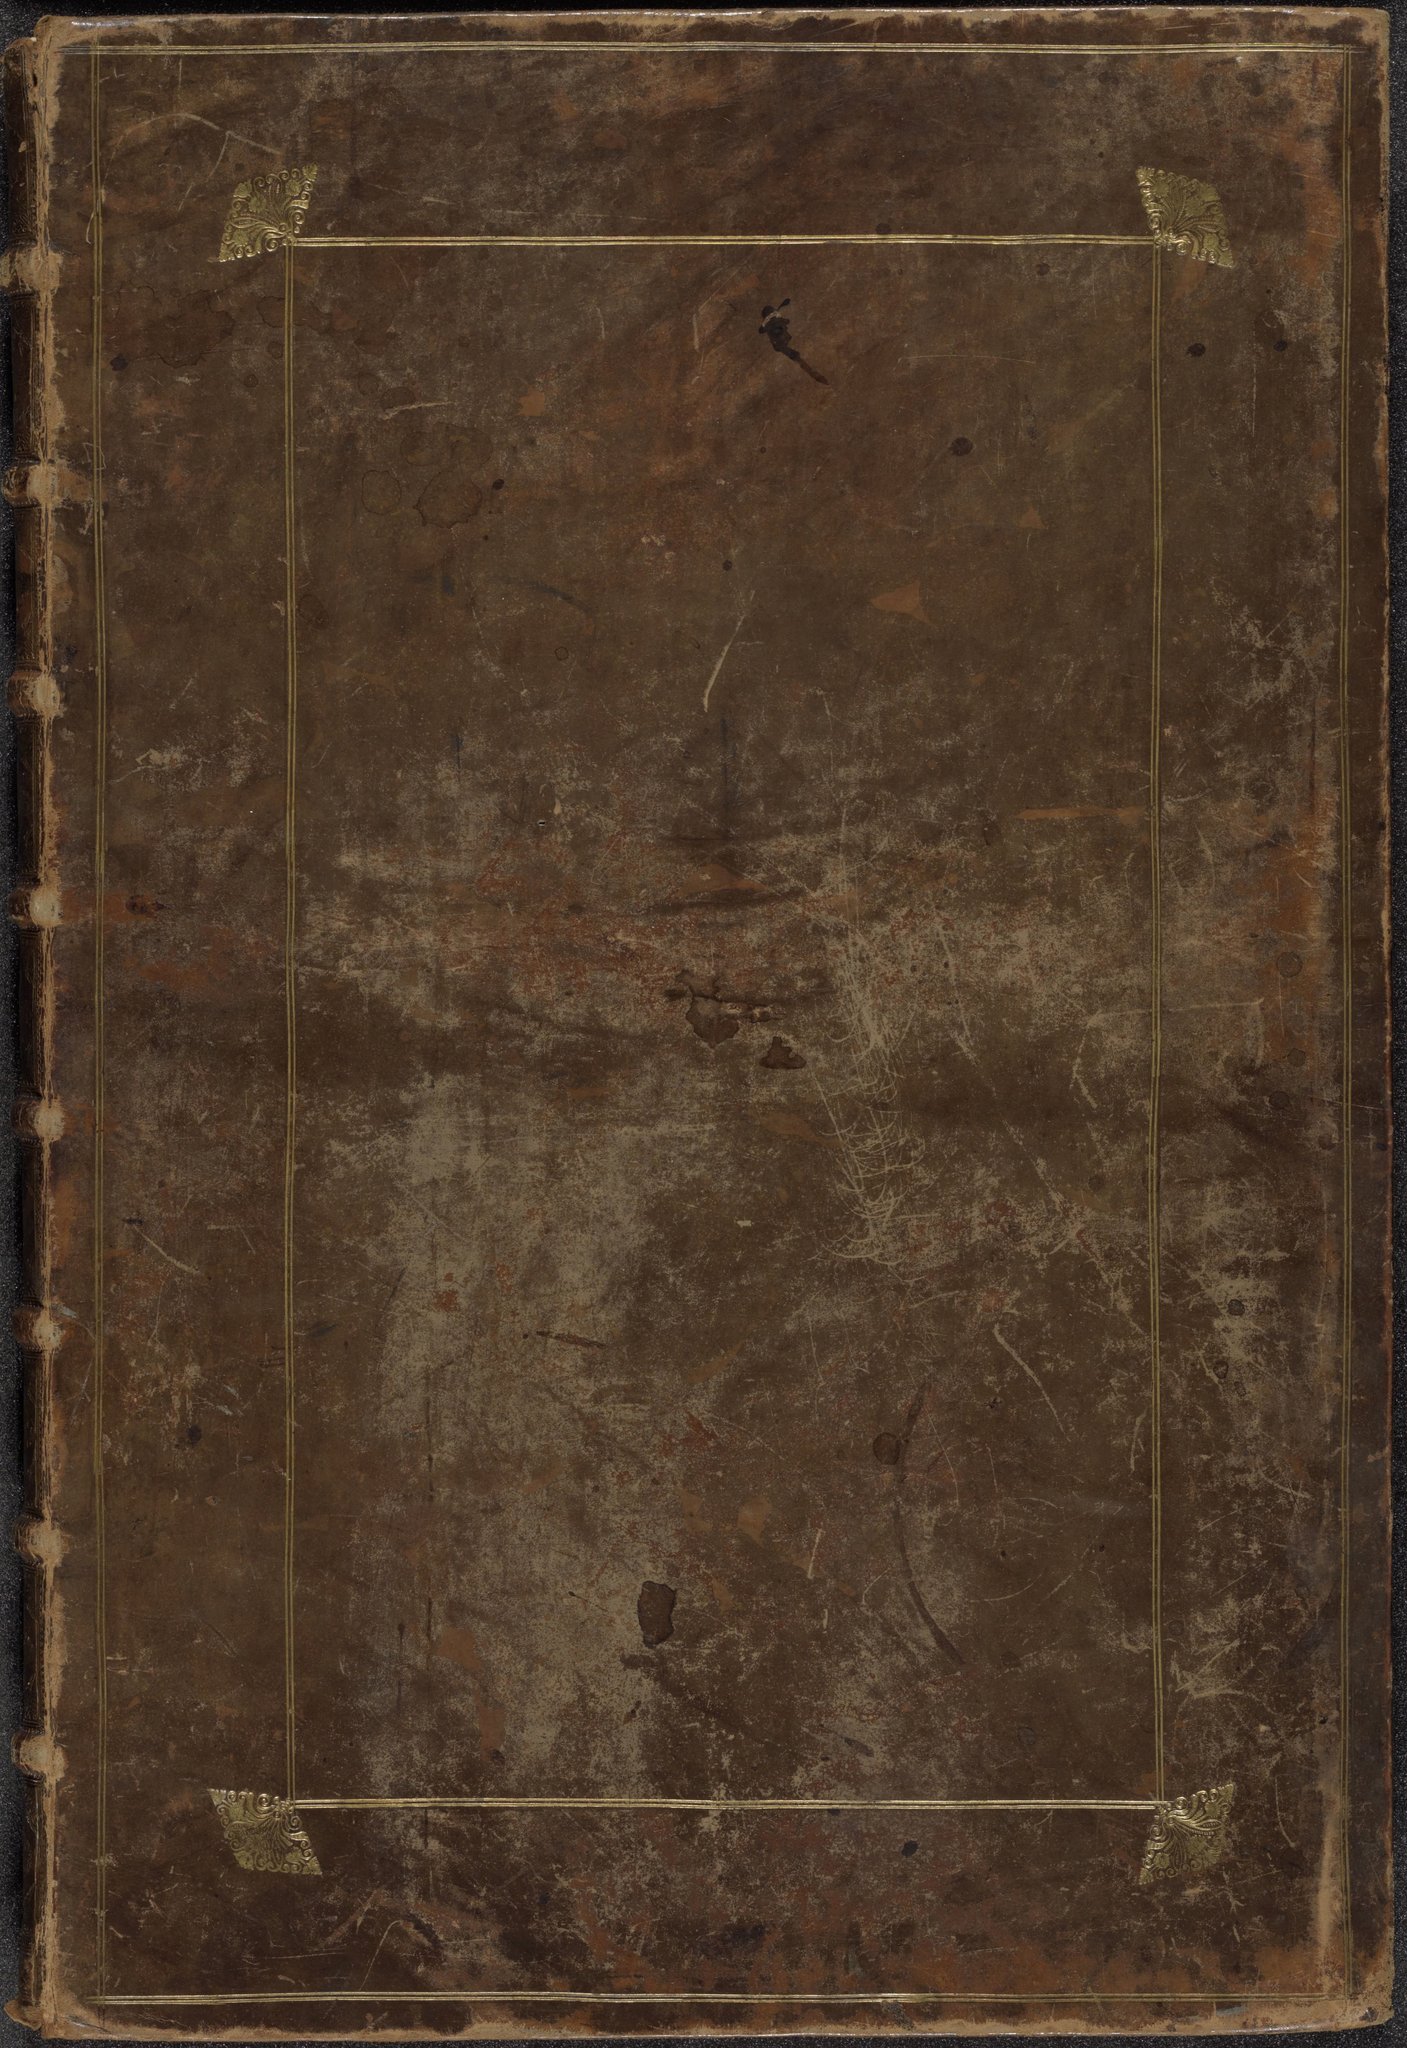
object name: prentrecueil, prentenalbum, prentalbum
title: Album met in kleur gedrukte prenten uit de onderneming van Johan Teyler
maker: johan teyler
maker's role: draughtsman, print maker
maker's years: 1648-1712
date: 1688-1698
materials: leather, gold leaf, paper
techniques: bookbinding, printing, engraving, etching, hand coloring, lithography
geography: netherlands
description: Album met 135 in kleur gedrukte prenten op 80 albumbladen in een kalfsleren band bedrukt met stempels in bladgoud. Het album is waarschijnlijk samengesteld en gebonden in Amsterdam. Op een aantal albumbladen met ingebonden prenten zijn prenten bijgeplakt.